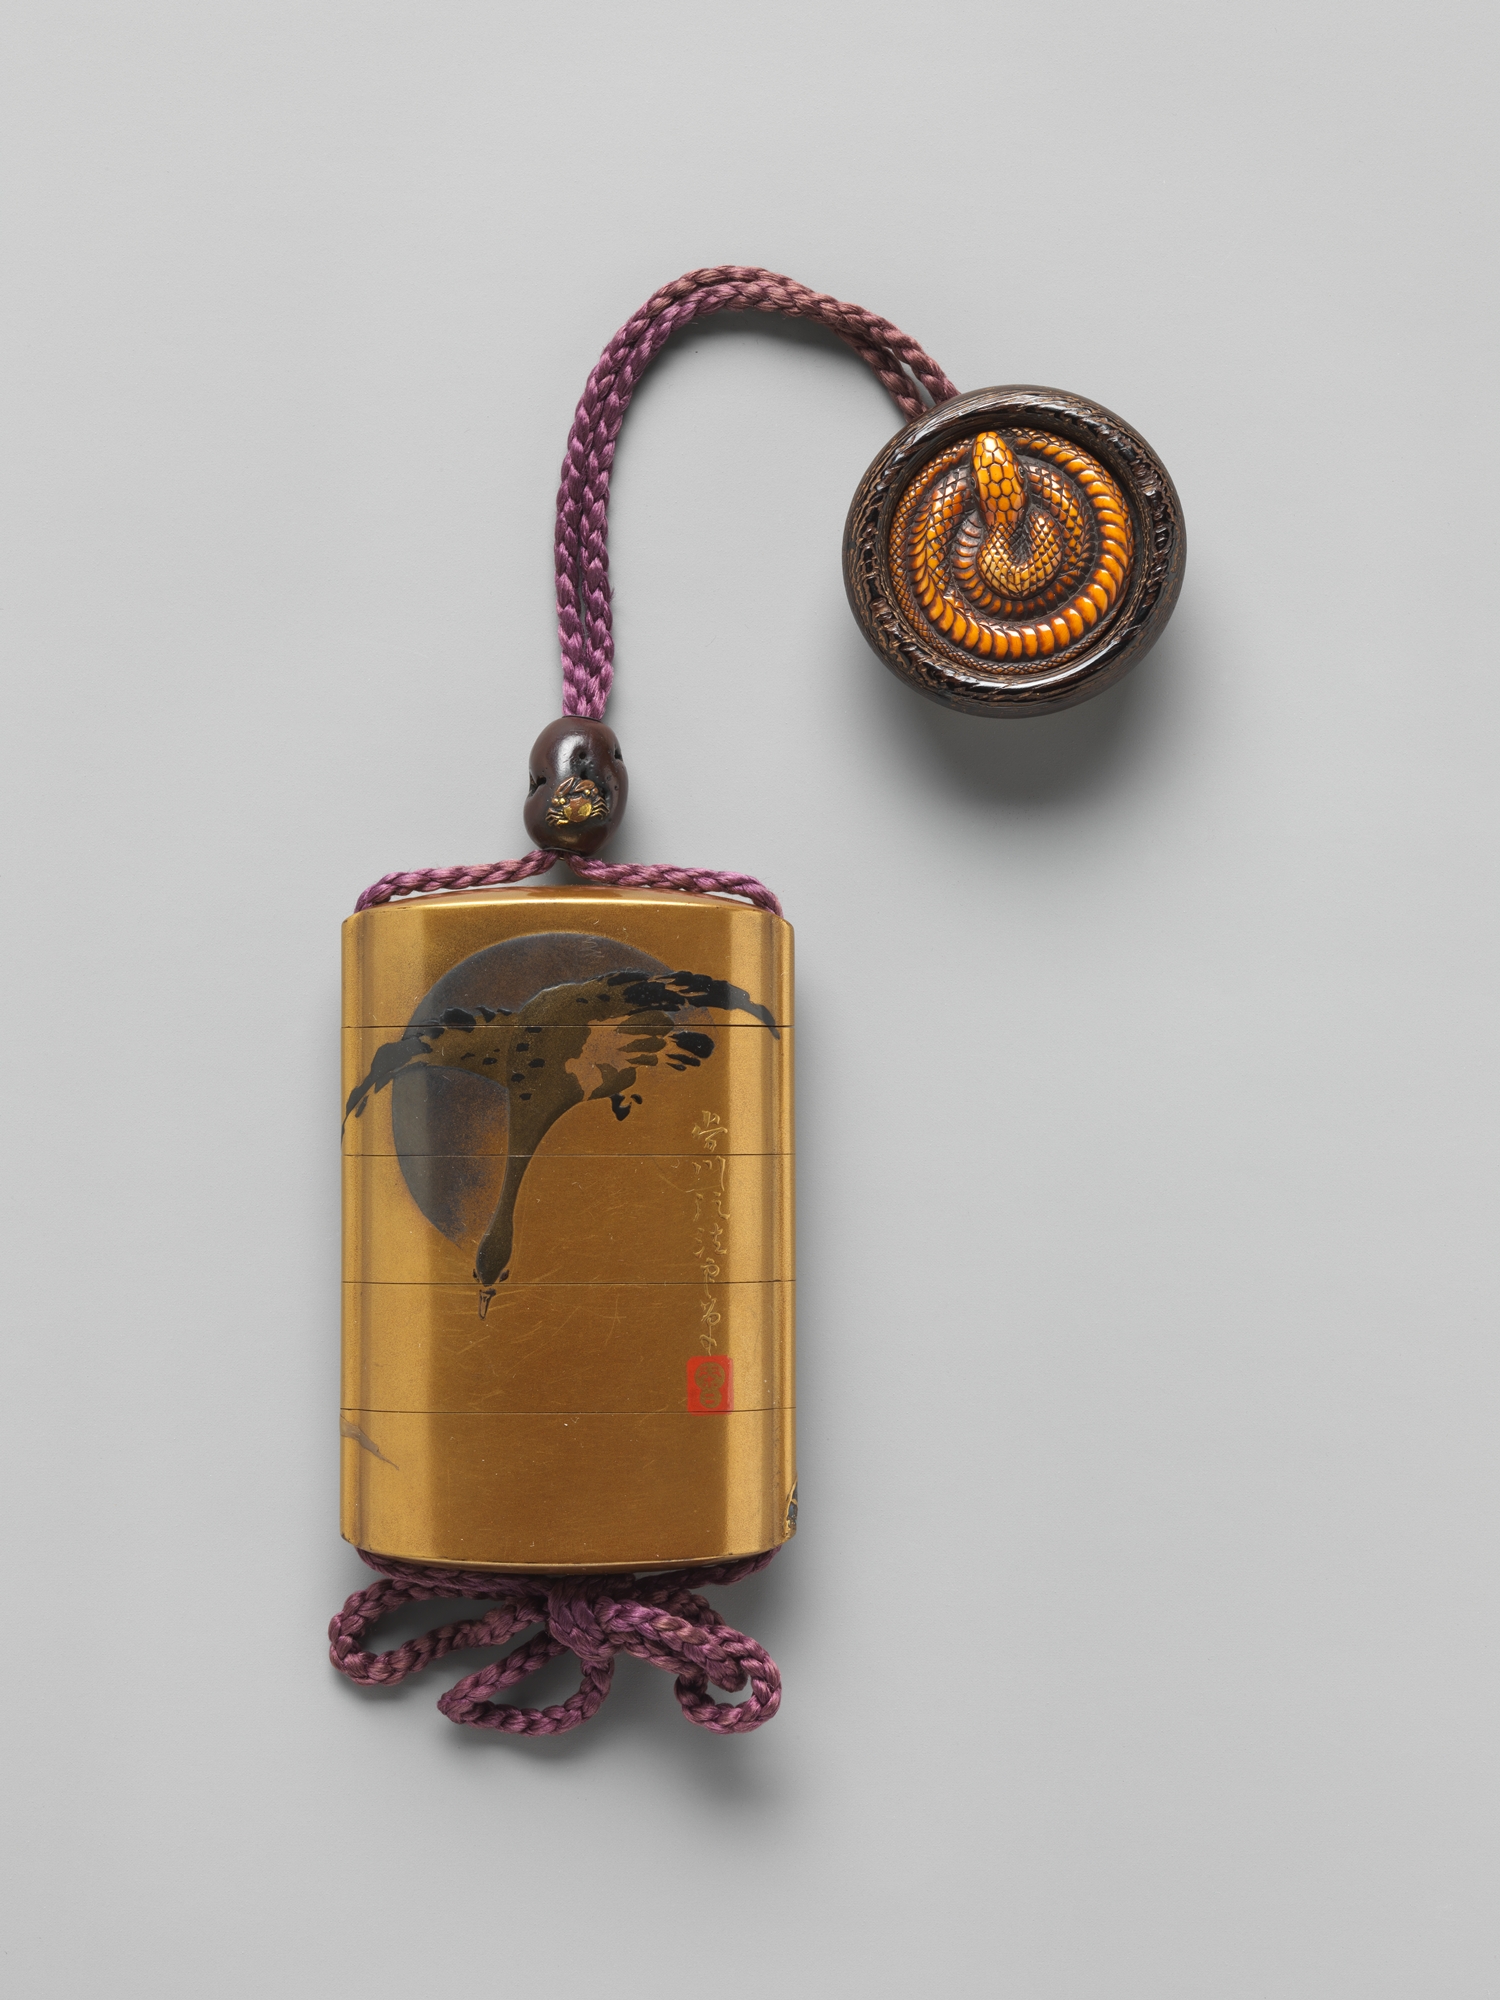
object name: inrō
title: Inrō with Goose Flying across the Full Moon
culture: japanese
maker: kano seisen’in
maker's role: artist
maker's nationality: japanese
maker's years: 1775-1828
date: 1801-1900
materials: gold, lacquer, silver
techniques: fundame, hiramakie, inlay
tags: geese,crabs,snakes,moon